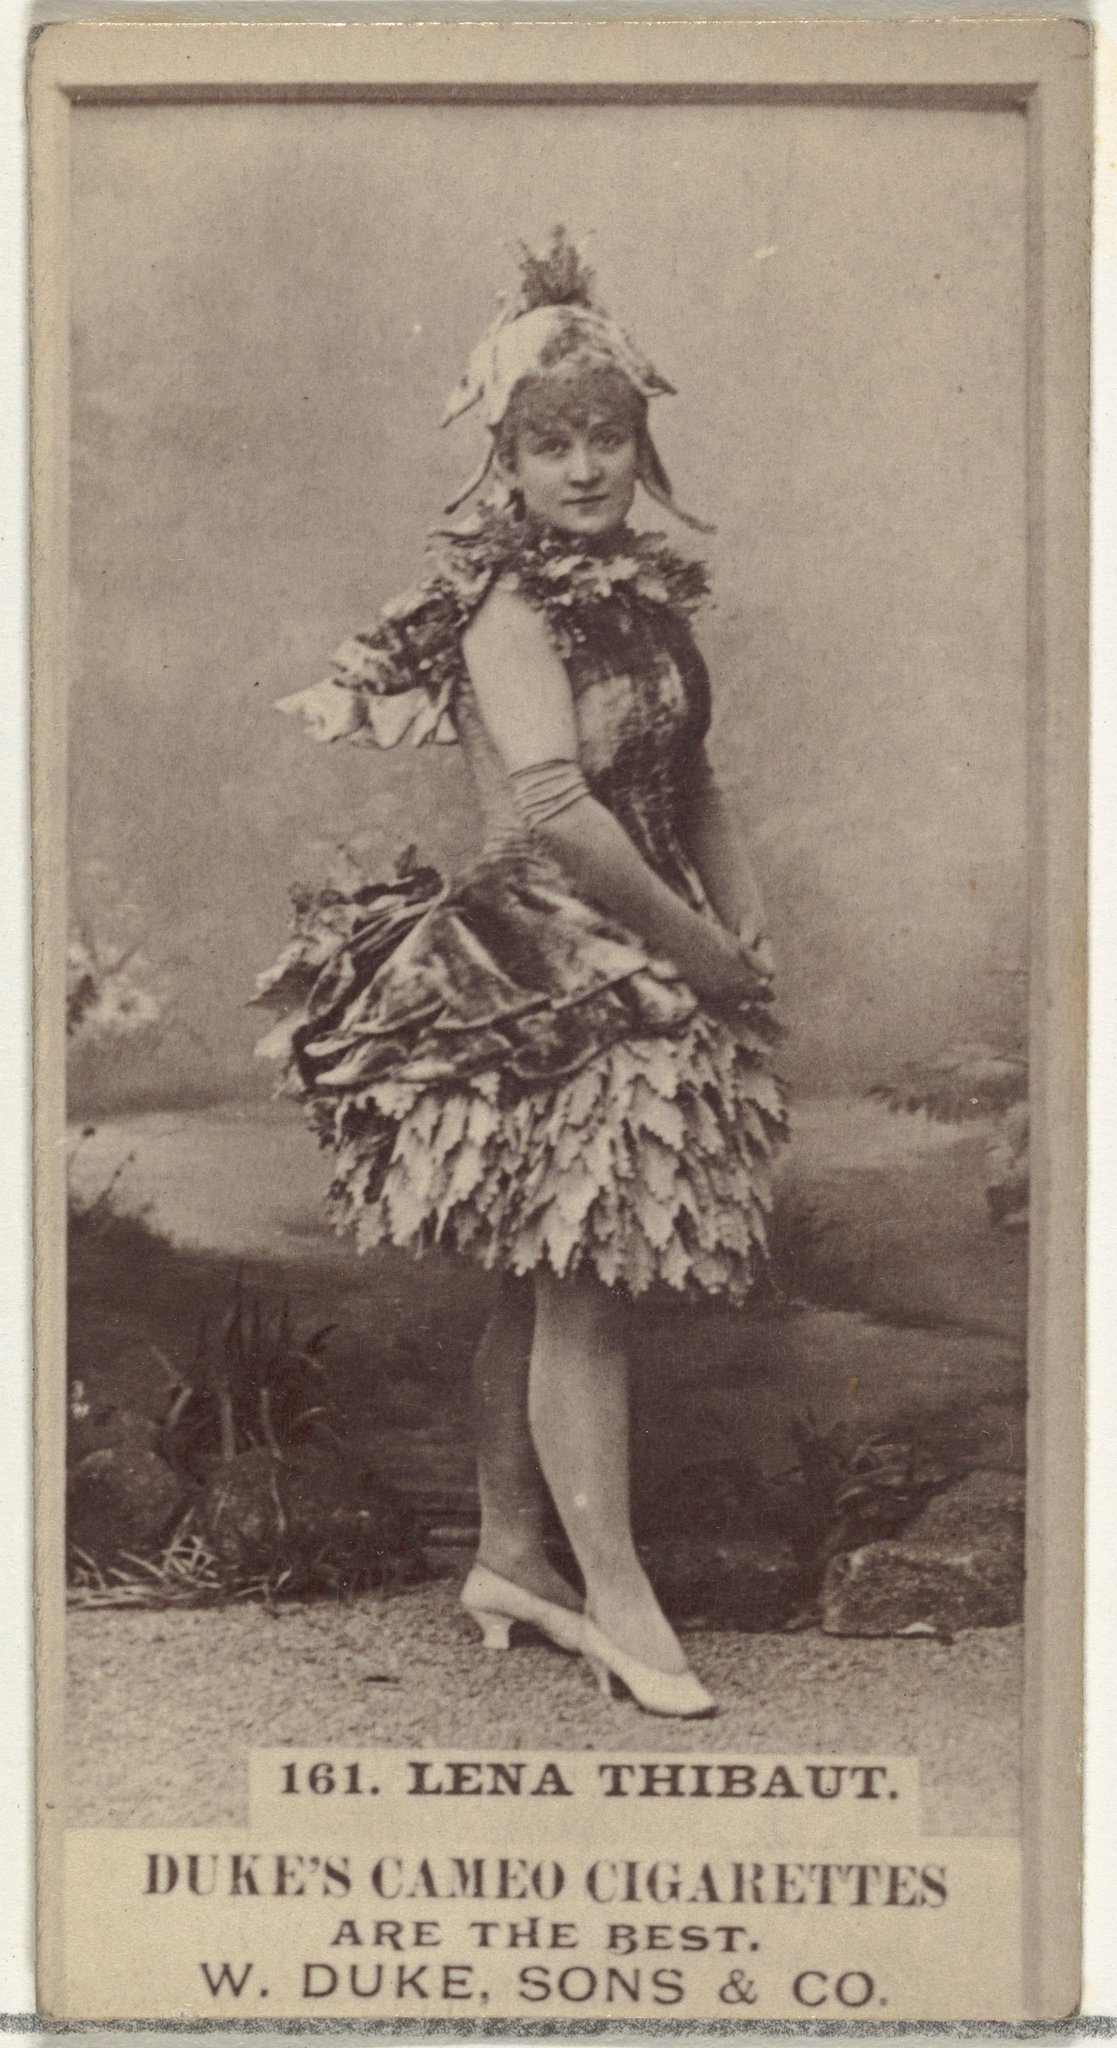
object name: photograph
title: Card Number 161, Lena Thibaut, from the Actors and Actresses series (N145-5) issued by Duke Sons & Co. to promote Cameo Cigarettes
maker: w. duke, sons & co.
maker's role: publisher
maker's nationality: american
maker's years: 1870-1920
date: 1880-1889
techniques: albumen silver print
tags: portraits,women,actresses